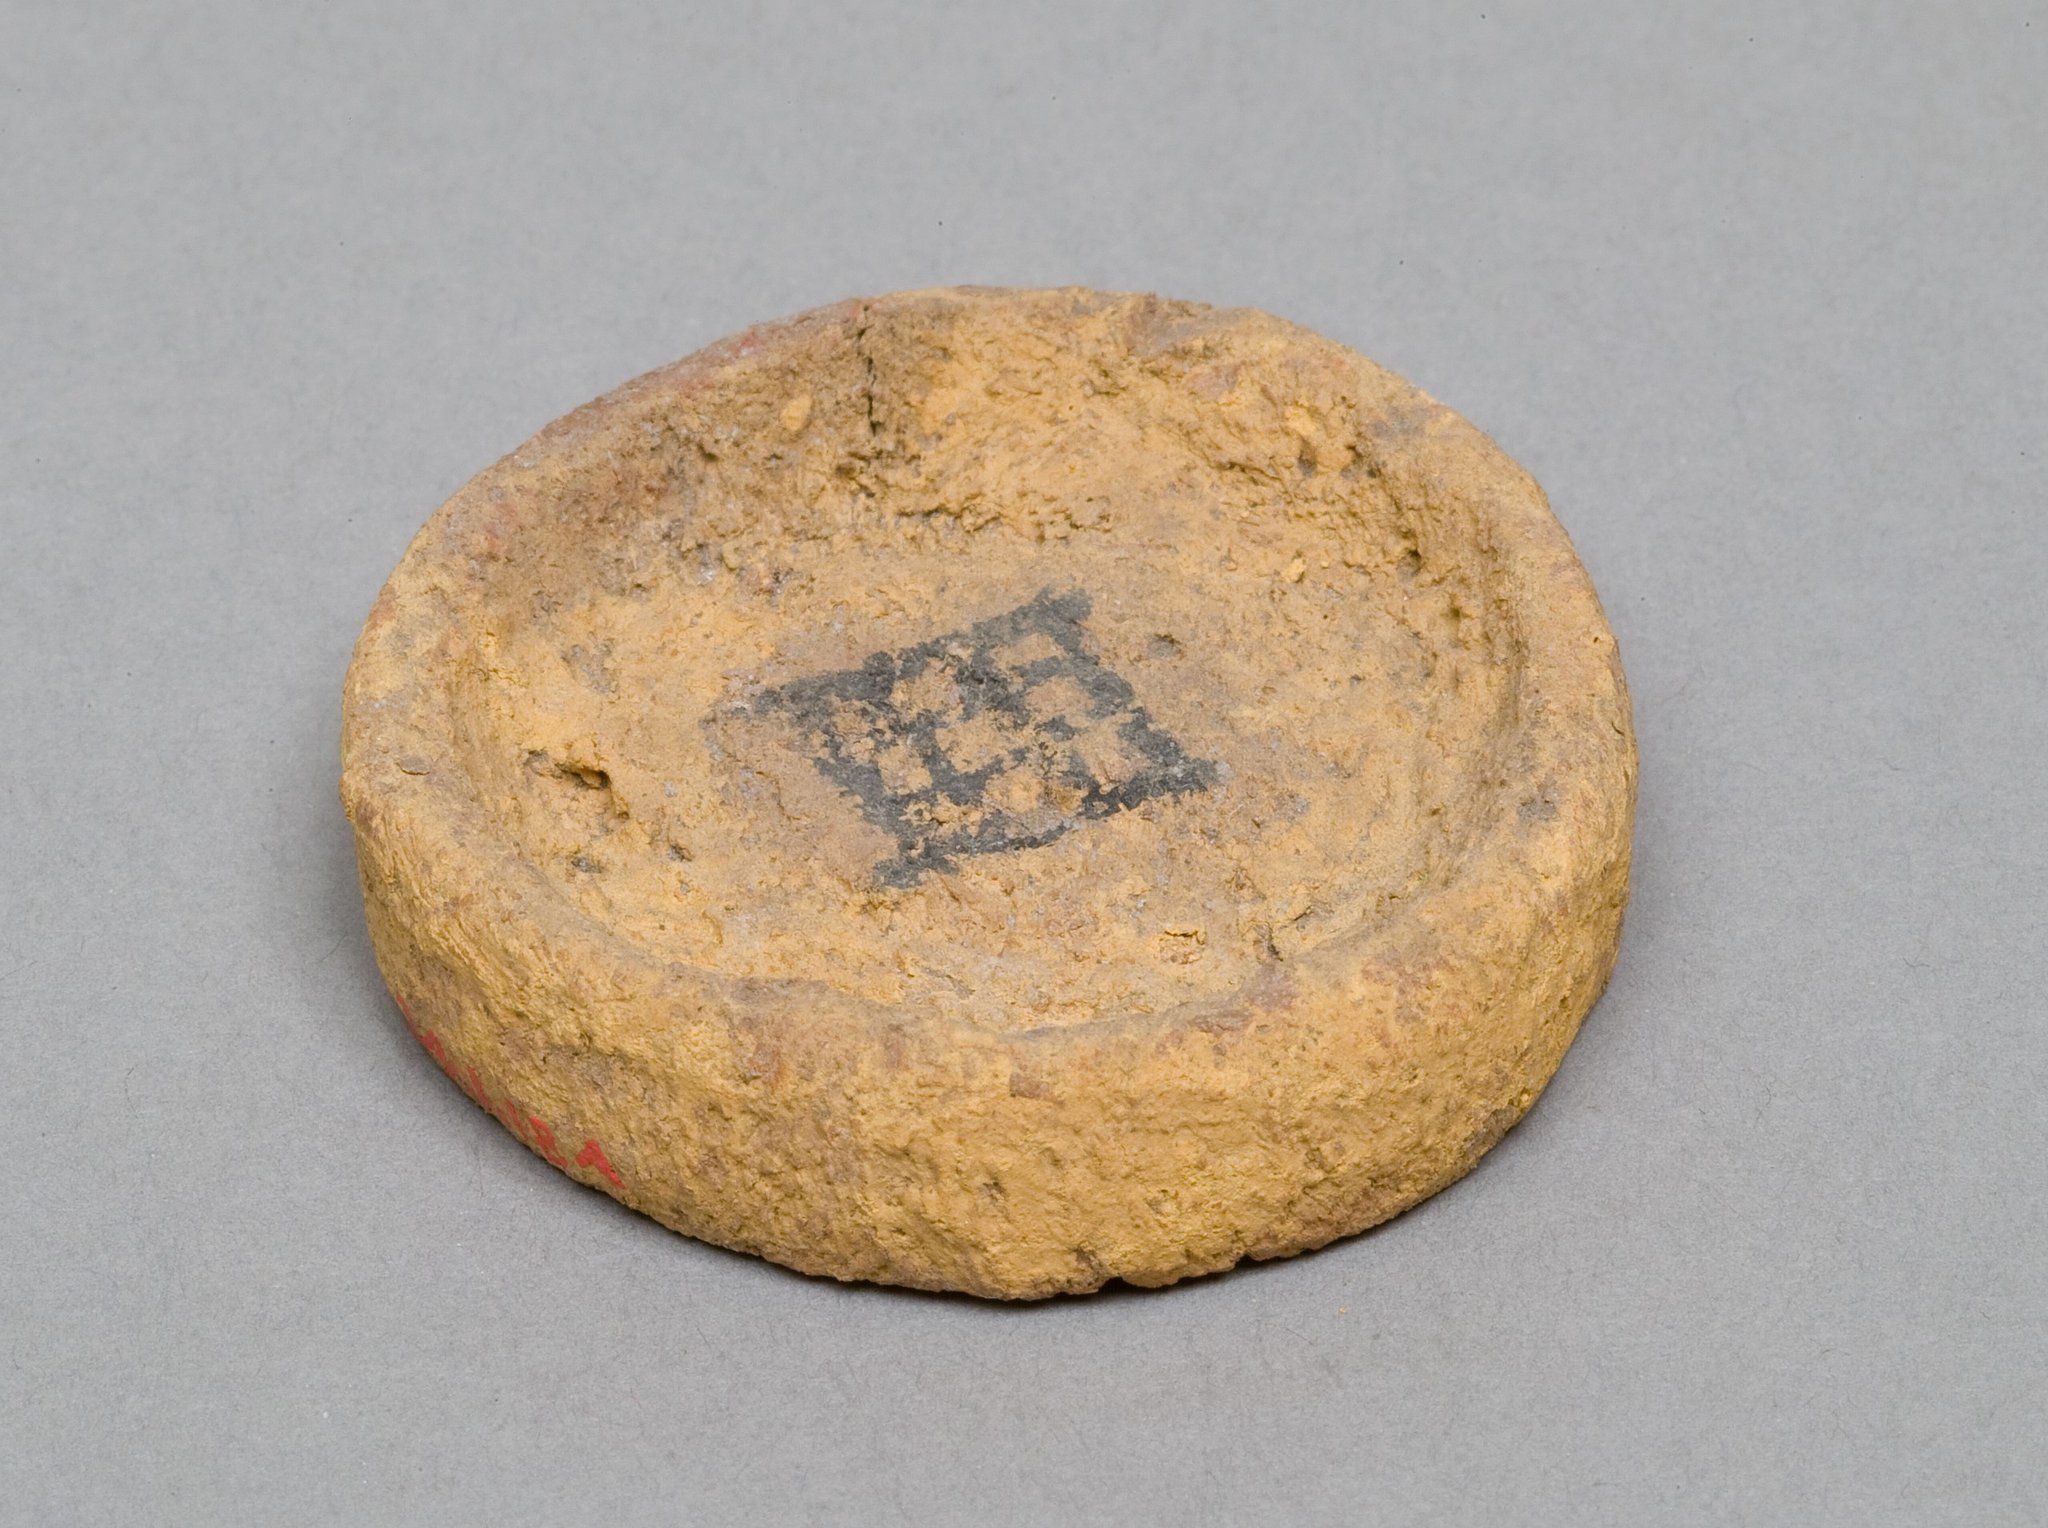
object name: sieve model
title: Model sieve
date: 1981-1640 BCE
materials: paint, wood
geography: egypt